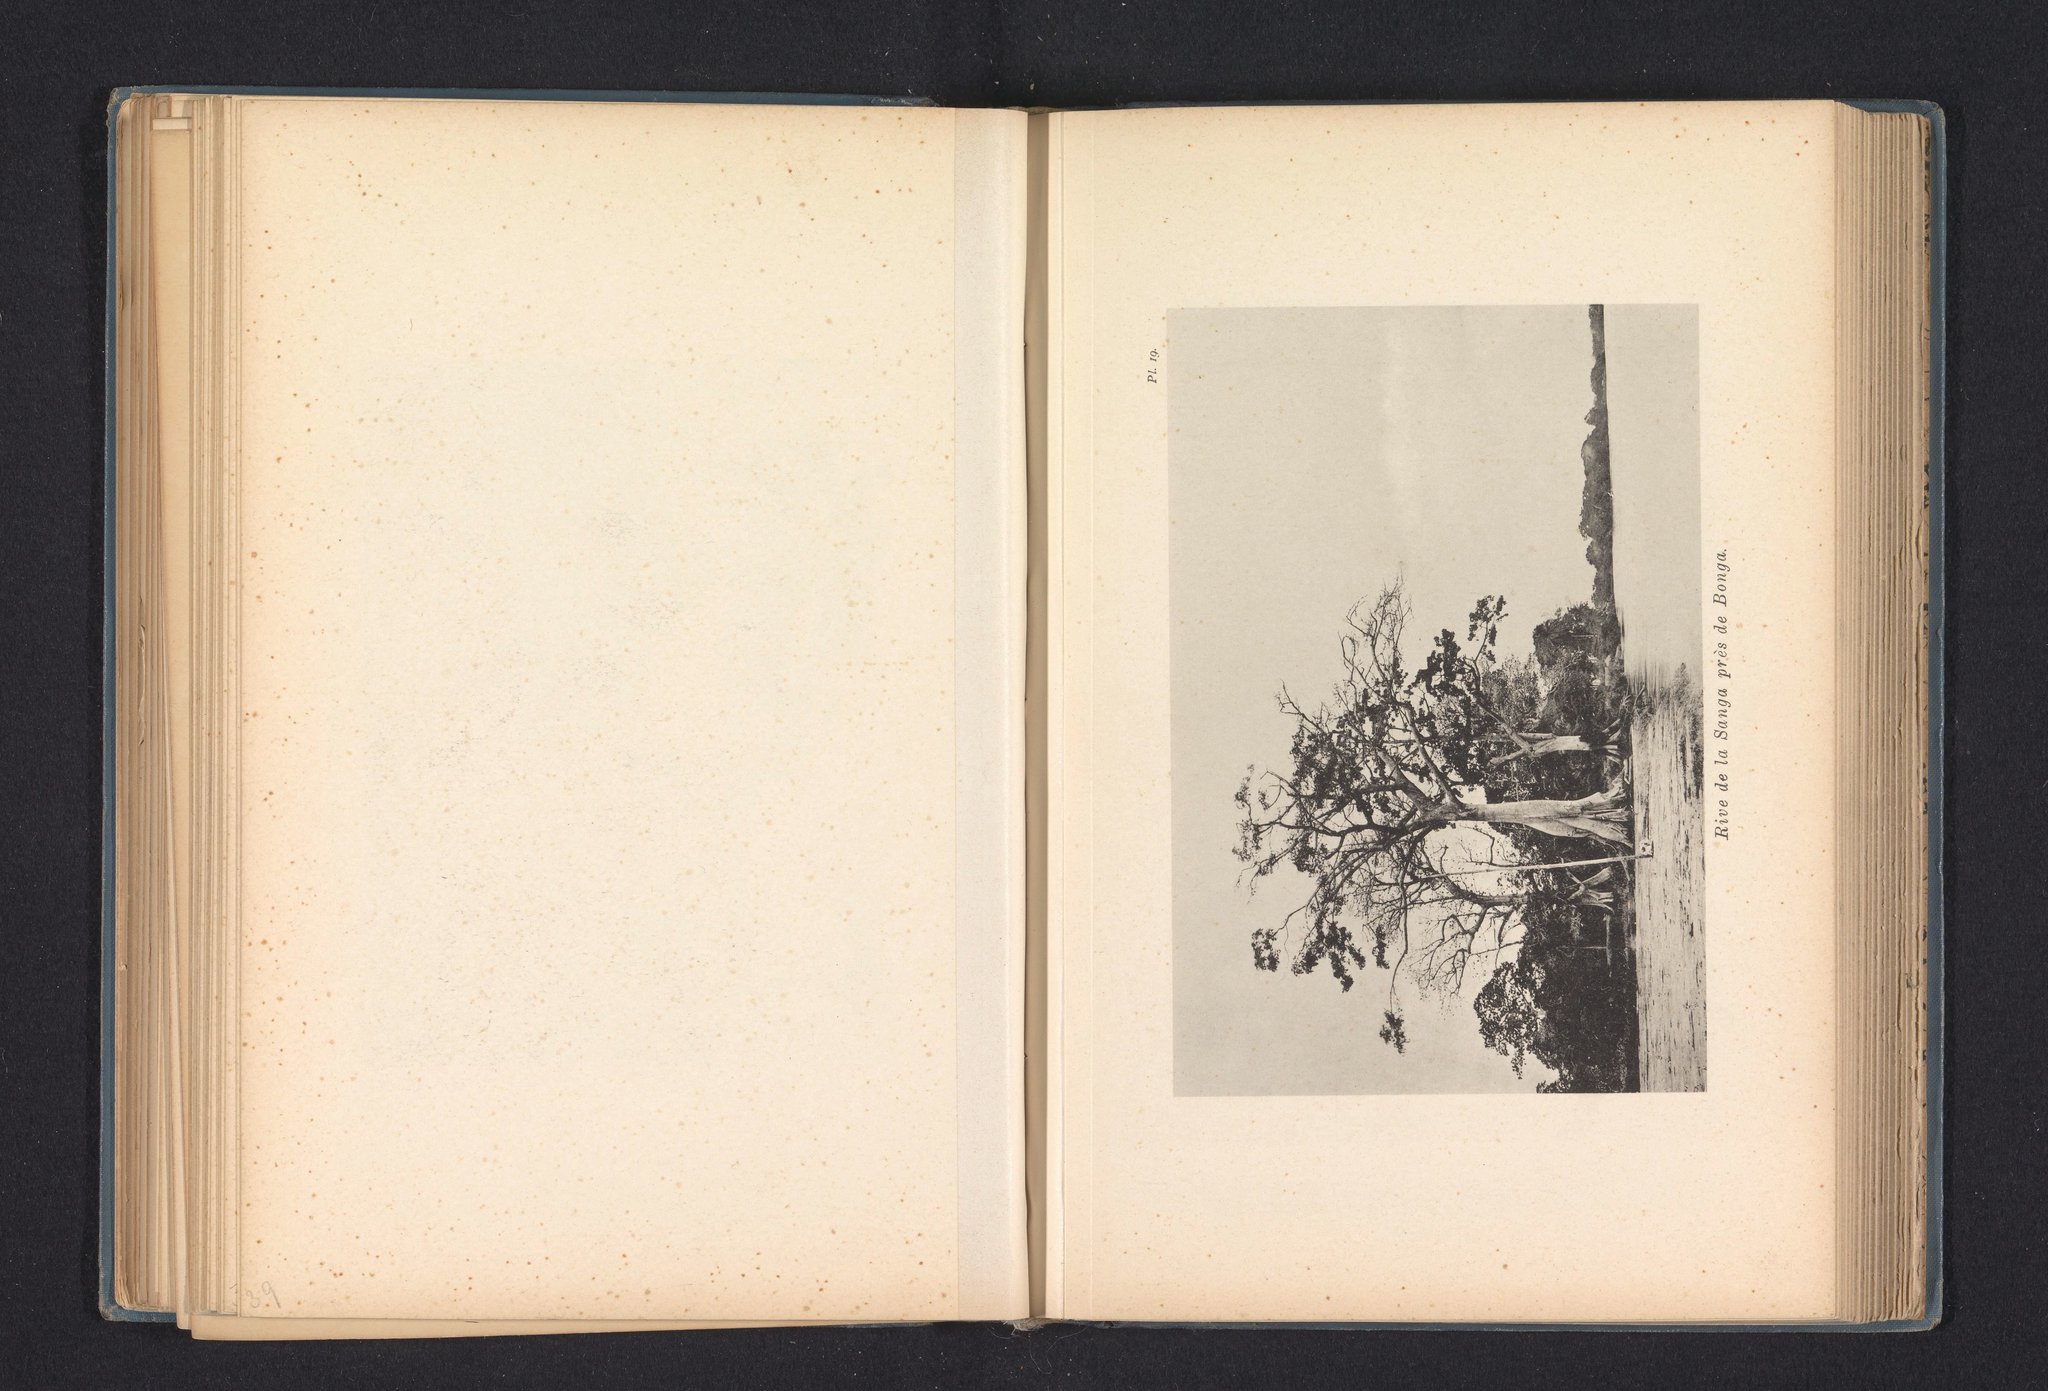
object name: photomechanical print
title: Oever van de Sangha nabij Bonga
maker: franz thonner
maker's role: botanicus, ontdekkingsreiziger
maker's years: 1863-1928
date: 1896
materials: paper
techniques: photograph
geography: sangha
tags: river bank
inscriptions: number: ‘Pl. 19.’